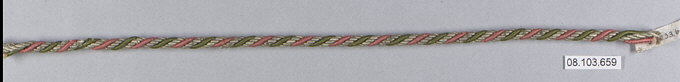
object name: cord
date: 1701-1900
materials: silk